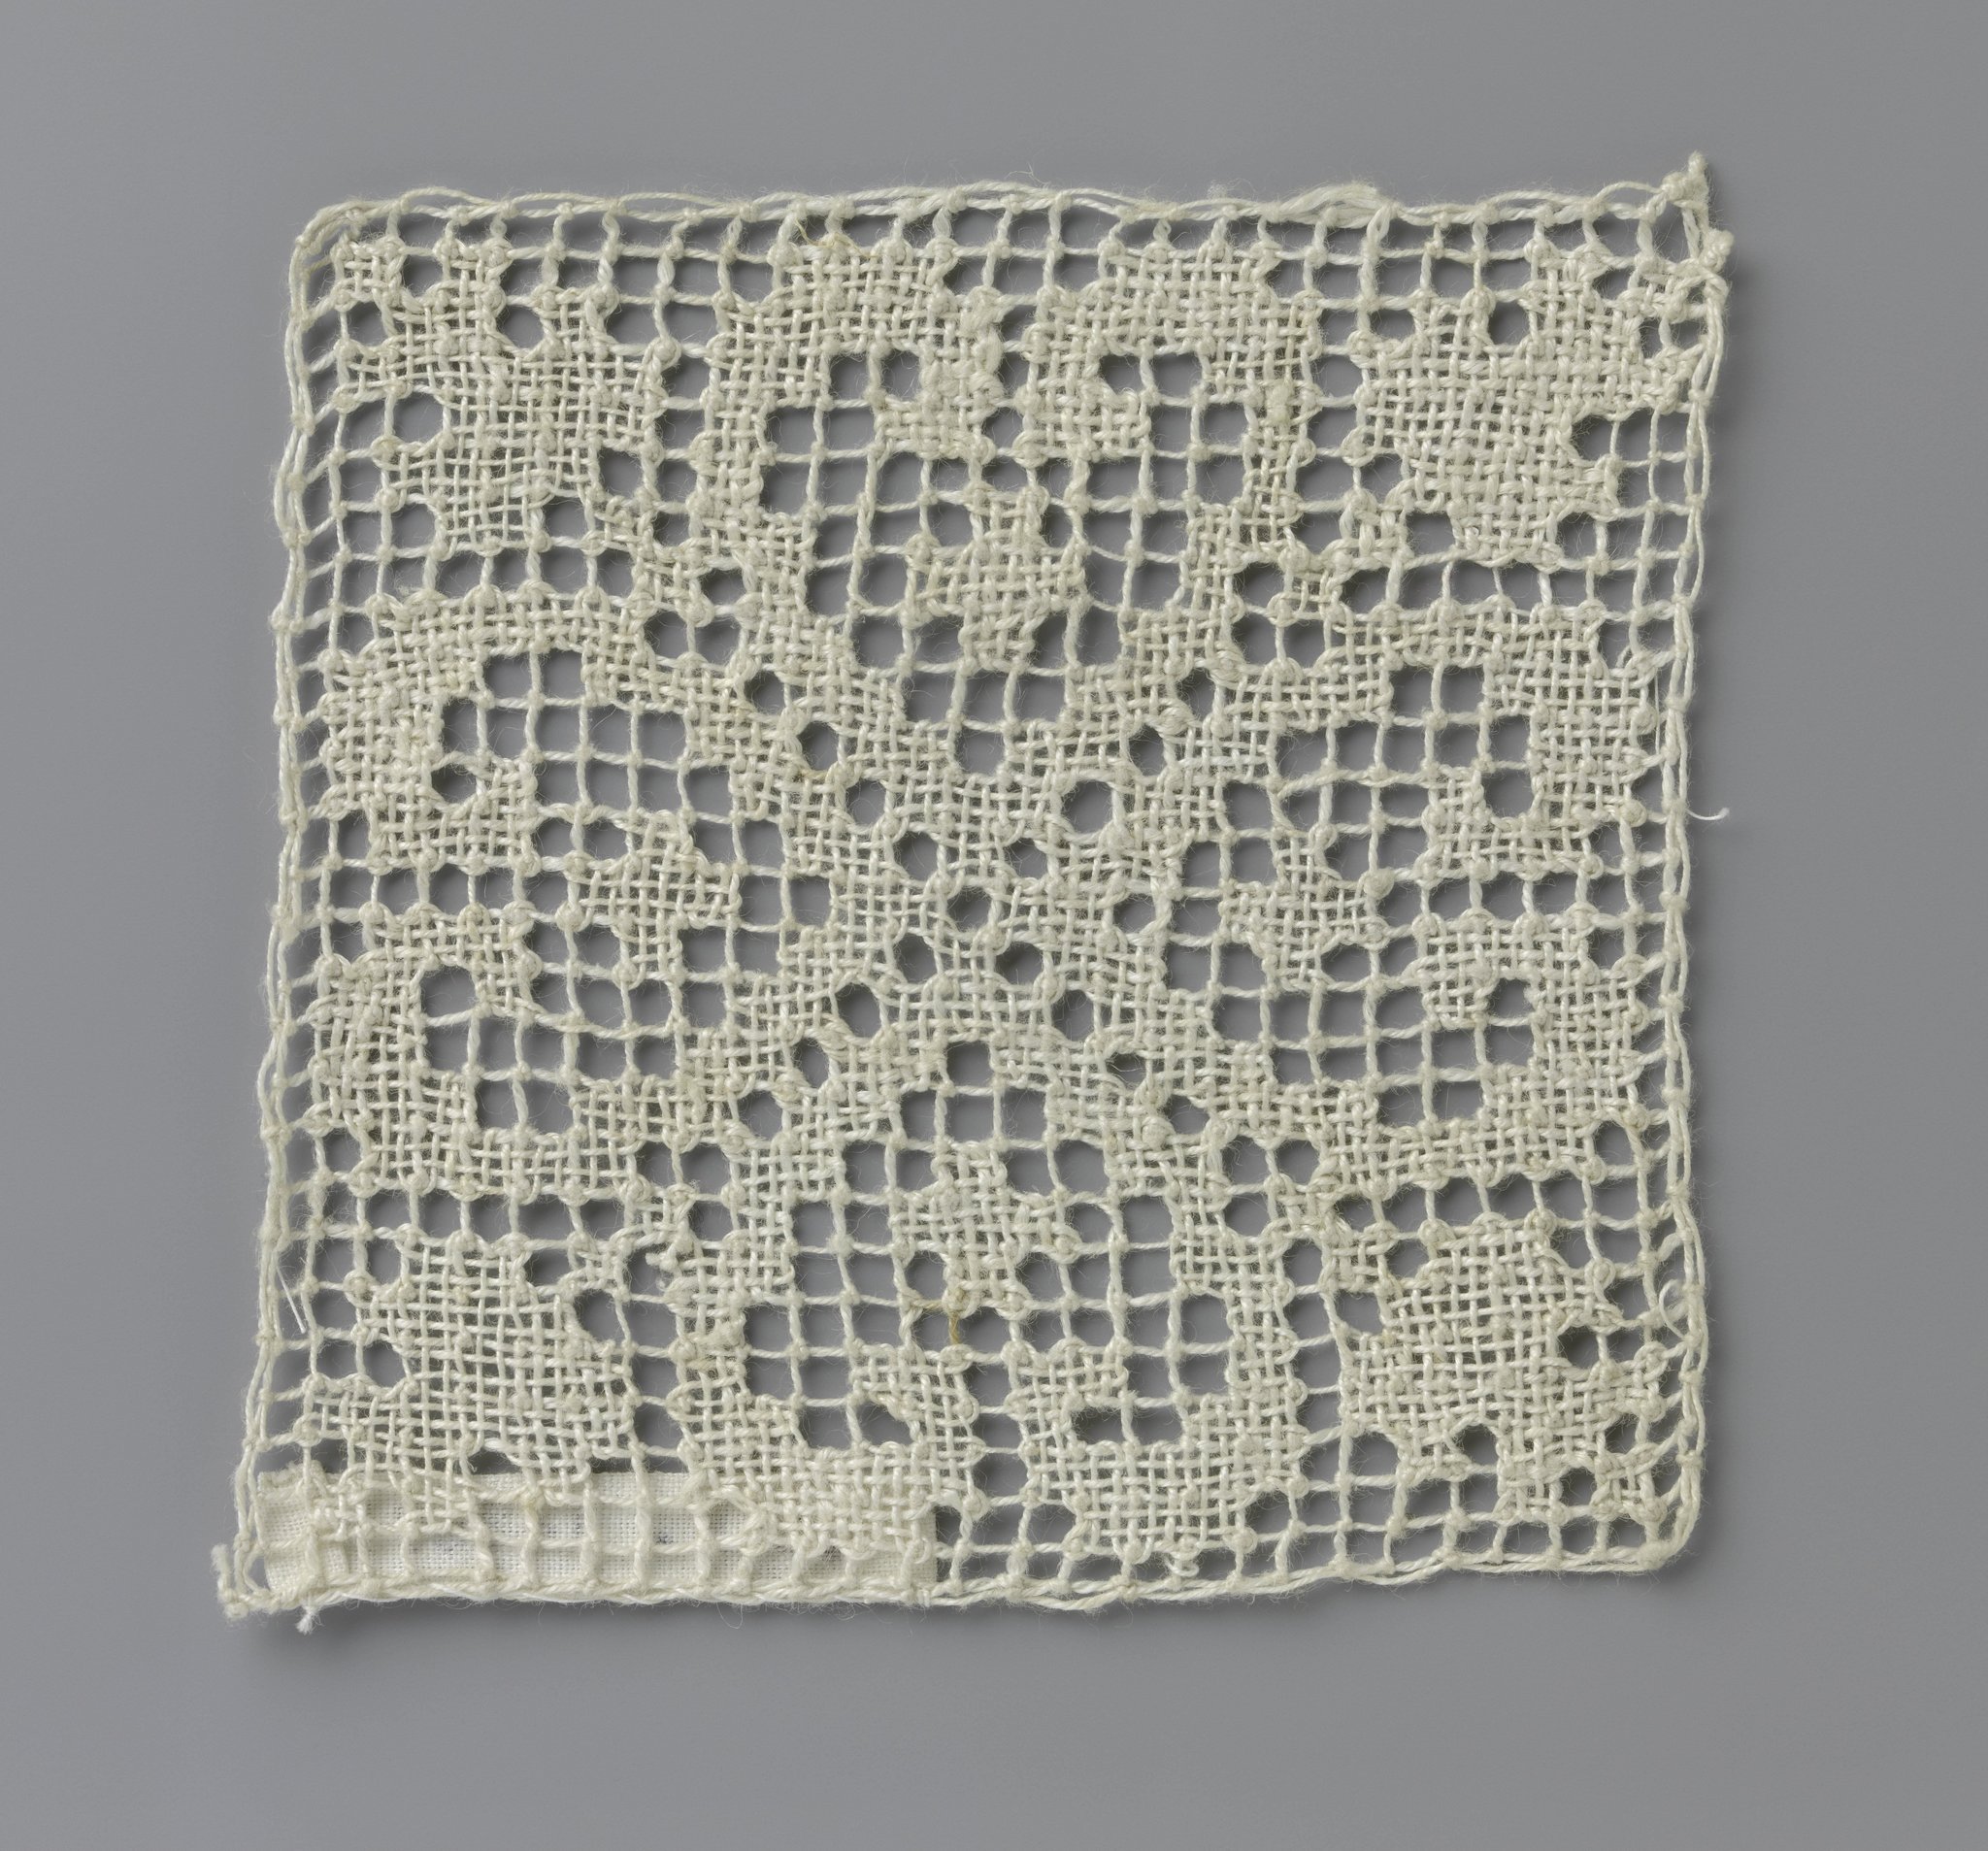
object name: mat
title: Vierkant kleedje van kantborduurwerk met rozetbloem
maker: Anonymous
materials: linen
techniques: embroidered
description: Vierkant kleedje van naturelkleurig kantborduurwerk: filetkant. Patroon met een rozetbloem van vier hartvormige blaadjes. Het motief is geborduurd op een geknoopt netwerk van vierkante mazen - filetknoopwerk - met de doorstoptechniek (linnenstopsteek). De zijden zijn recht afgewerkt.